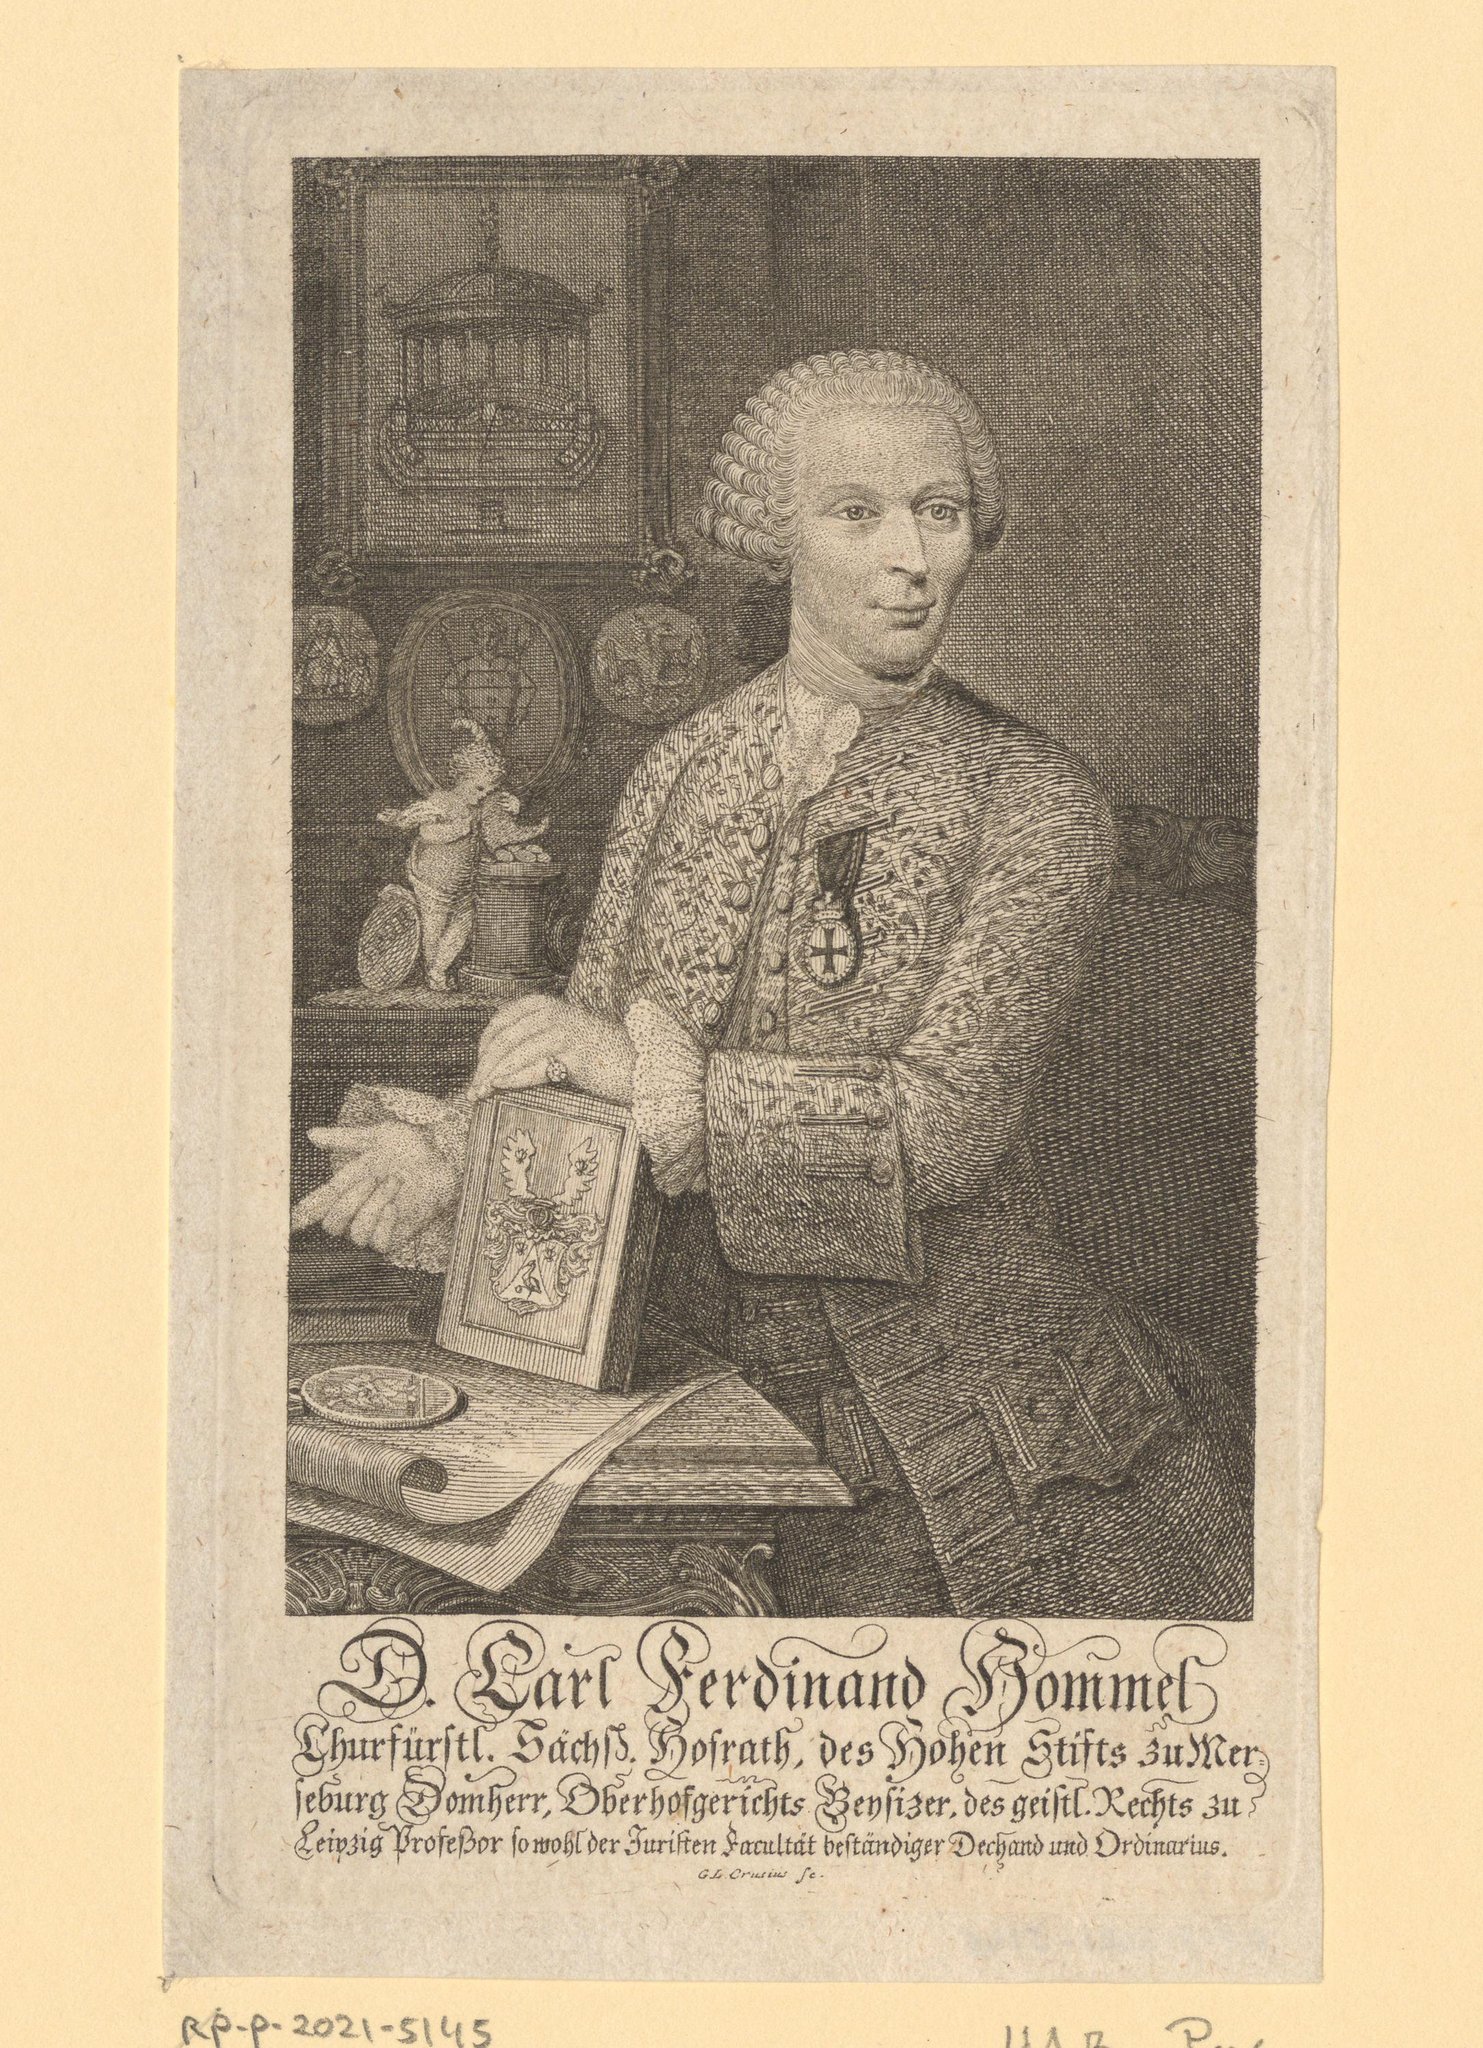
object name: print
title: Portret van Carl Ferdinand Hommel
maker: gottlieb leberecht crusius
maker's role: print maker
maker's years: 1730-1804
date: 1750-1804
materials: paper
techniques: engraving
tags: historical persons, book, interior of the house, armorial bearing, heraldry